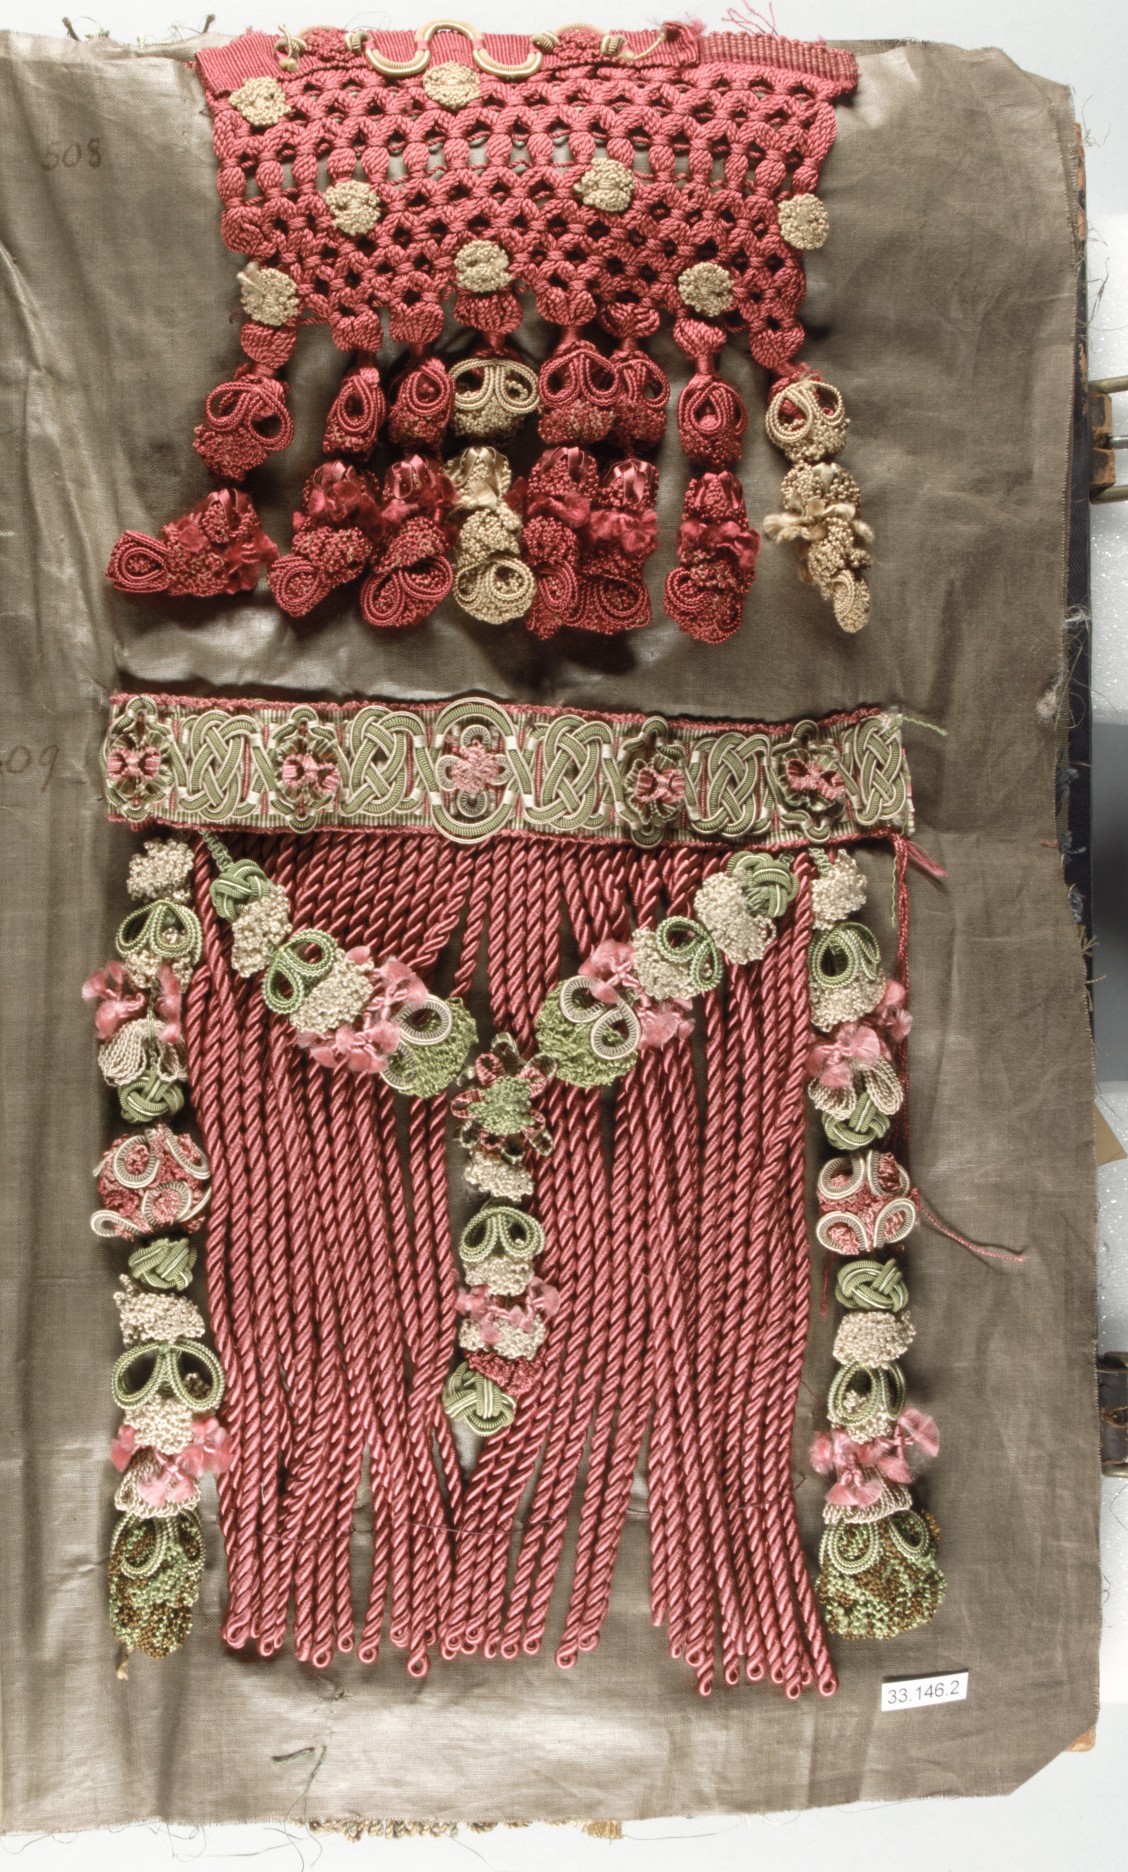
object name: sample book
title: Textile Sample Book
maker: morant and co.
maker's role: manufactory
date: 1701-1900